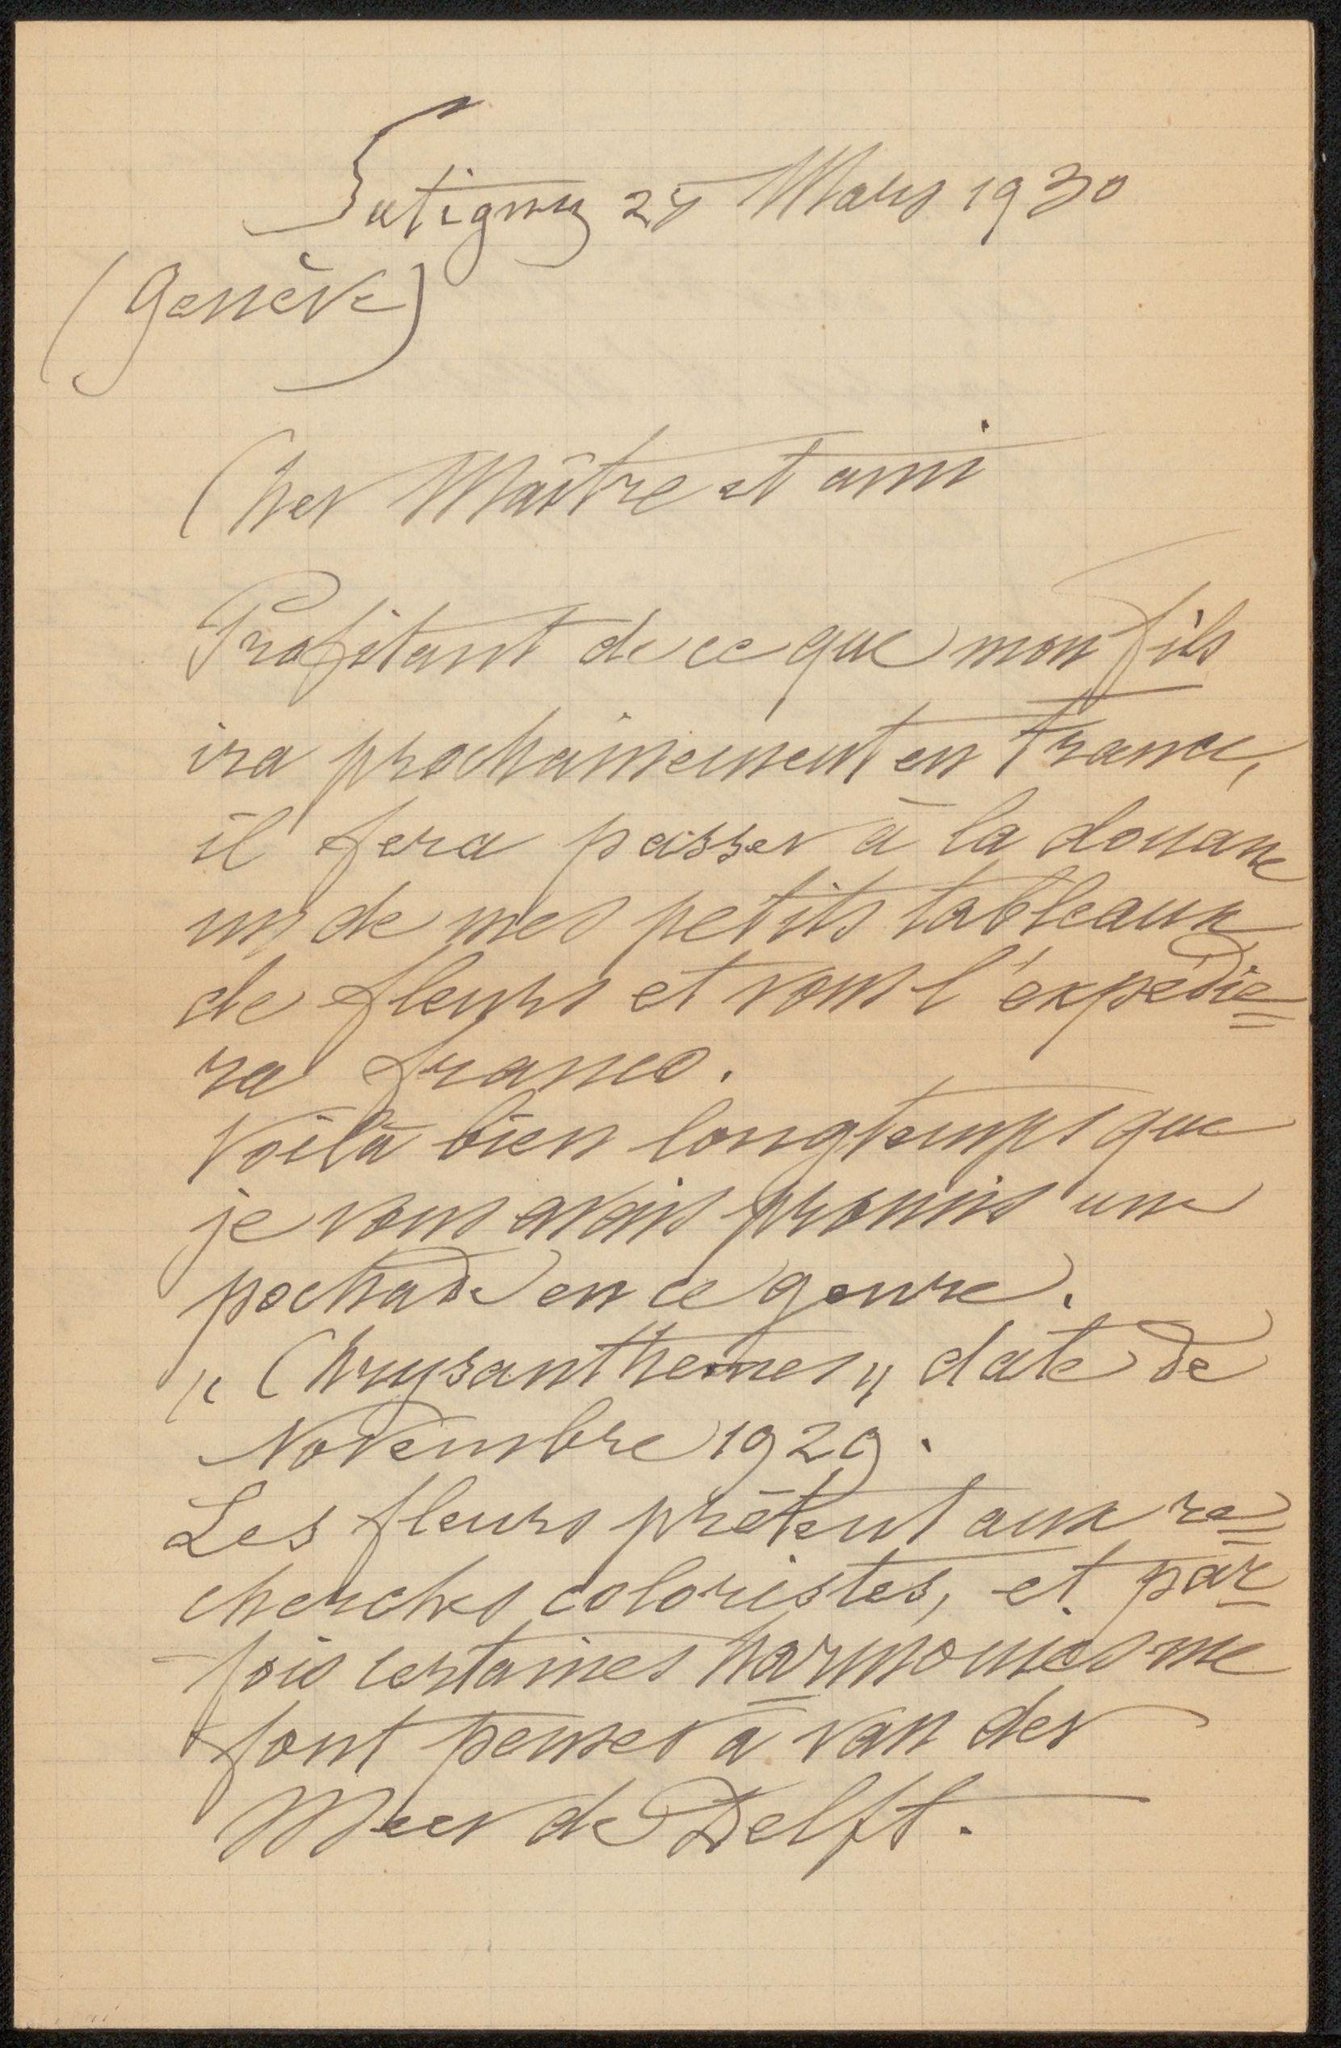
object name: letter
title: Brief aan Philip Zilcken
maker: alphonse stengelin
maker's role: painter, print maker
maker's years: 1852-1938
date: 1930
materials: ink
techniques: pen, writing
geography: satigny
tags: delft, painter, draughtsman, johannes vermeer, amsterdam, print maker, willem bastiaan tholen, the hague, philip zilcken, the graphic arts, painting (including book-illumination, miniature-painting), printed matter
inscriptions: collector's mark: ‘RPK’